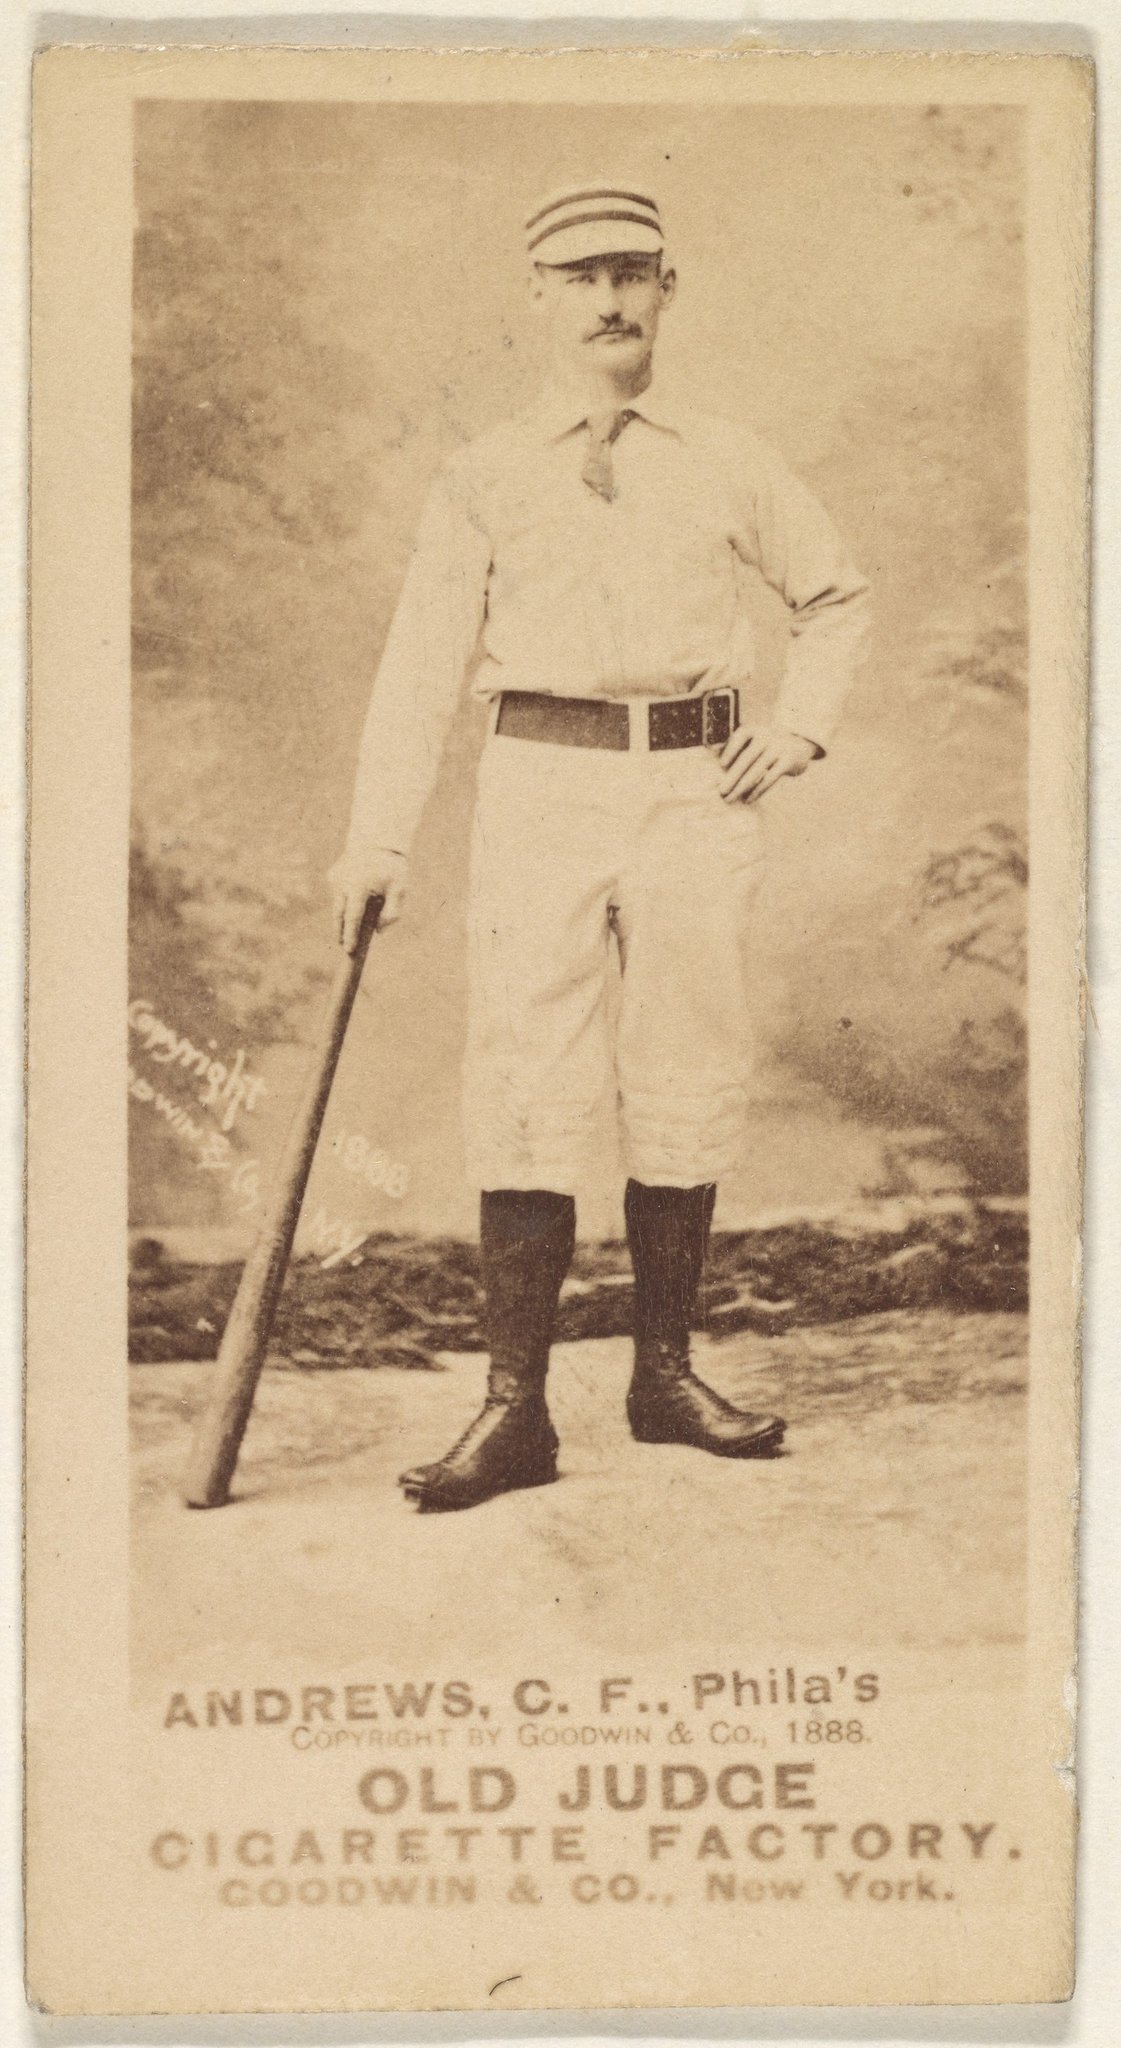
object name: baseball card, photograph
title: George Edward "Ed" Andrews, Center Field, Philadelphia, from the Old Judge series (N172) for Old Judge Cigarettes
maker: goodwin & company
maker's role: publisher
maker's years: 1850-1950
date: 1888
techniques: albumen silver print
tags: men,portraits,baseball,athletes